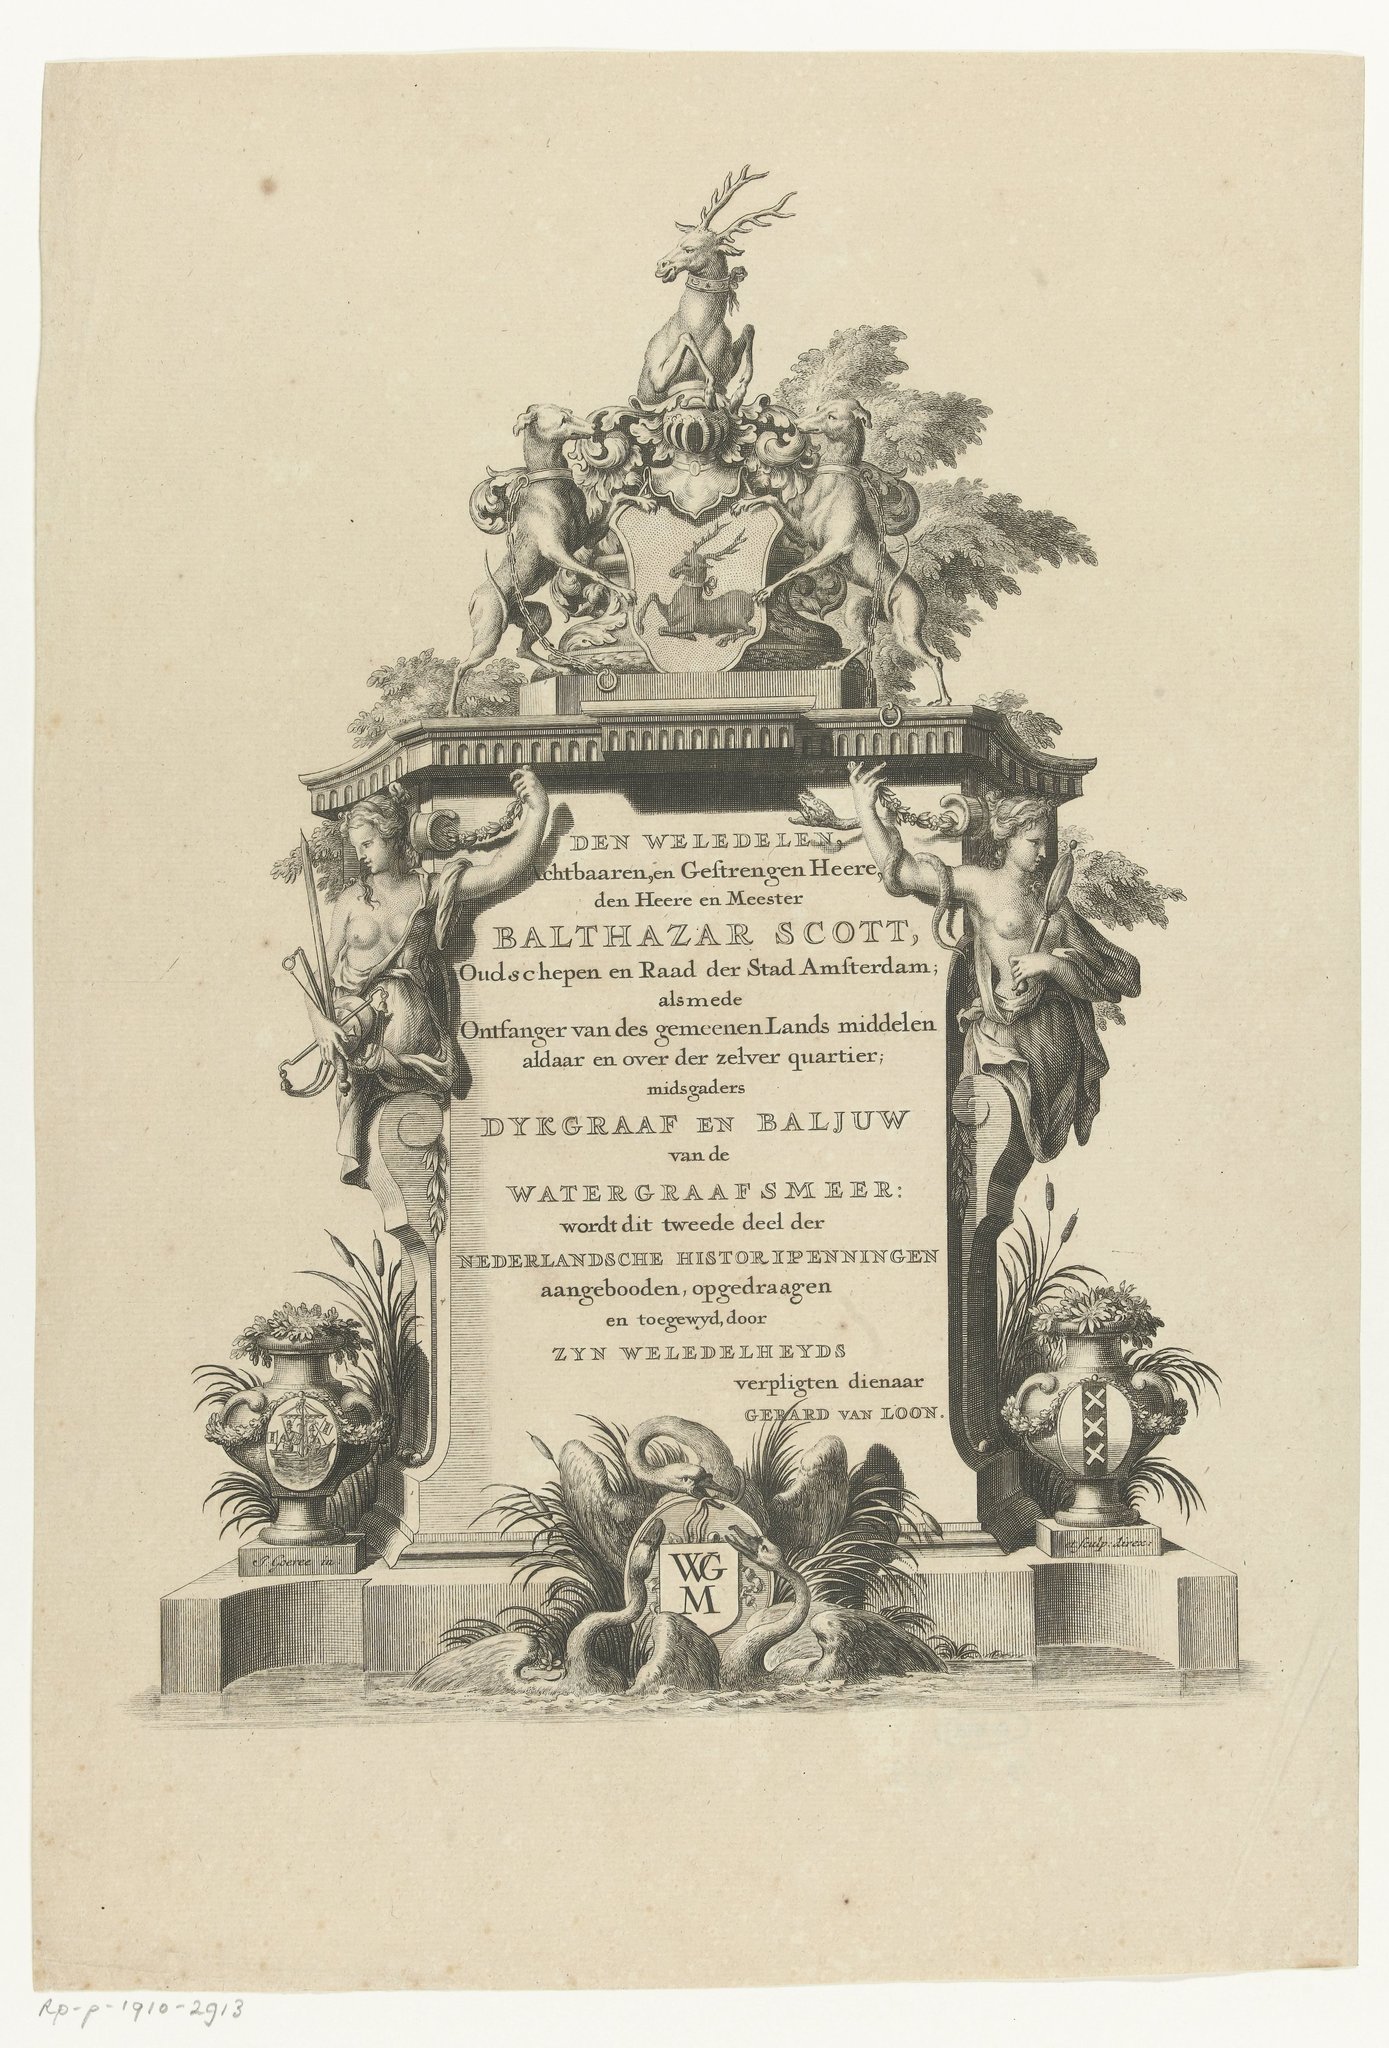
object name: print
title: Monument met opdracht aan Balthazar Scott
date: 1723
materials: paper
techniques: engraving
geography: amsterdam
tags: temperance, 'temperantia'; 'temperanza' (ripa) ~ one of the four cardinal virtues, prudence, 'prudentia'; 'prudenza' (ripa) ~ one of the four cardinal virtues, water-birds: swan, hoofed animals: stag, monument, statue, dog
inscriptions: collector's mark: Lugt 2228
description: In het midden een monument met een Nederlands opschrift met een opdracht aan Balthazar Scott, oud-schepen van Amsterdam. De beelden van de personificaties Matigheid en Voorzienigheid versieren het front van het monument. Bovenop het monument twee honden die een wapenschild vasthouden met daarop een hert: het blazoen van Balthazar Scott. Aan weerszijden van het monument twee ornamentele kruiken met de blazoenen van Amsterdam. Onderaan een vijver met drie zwanen.